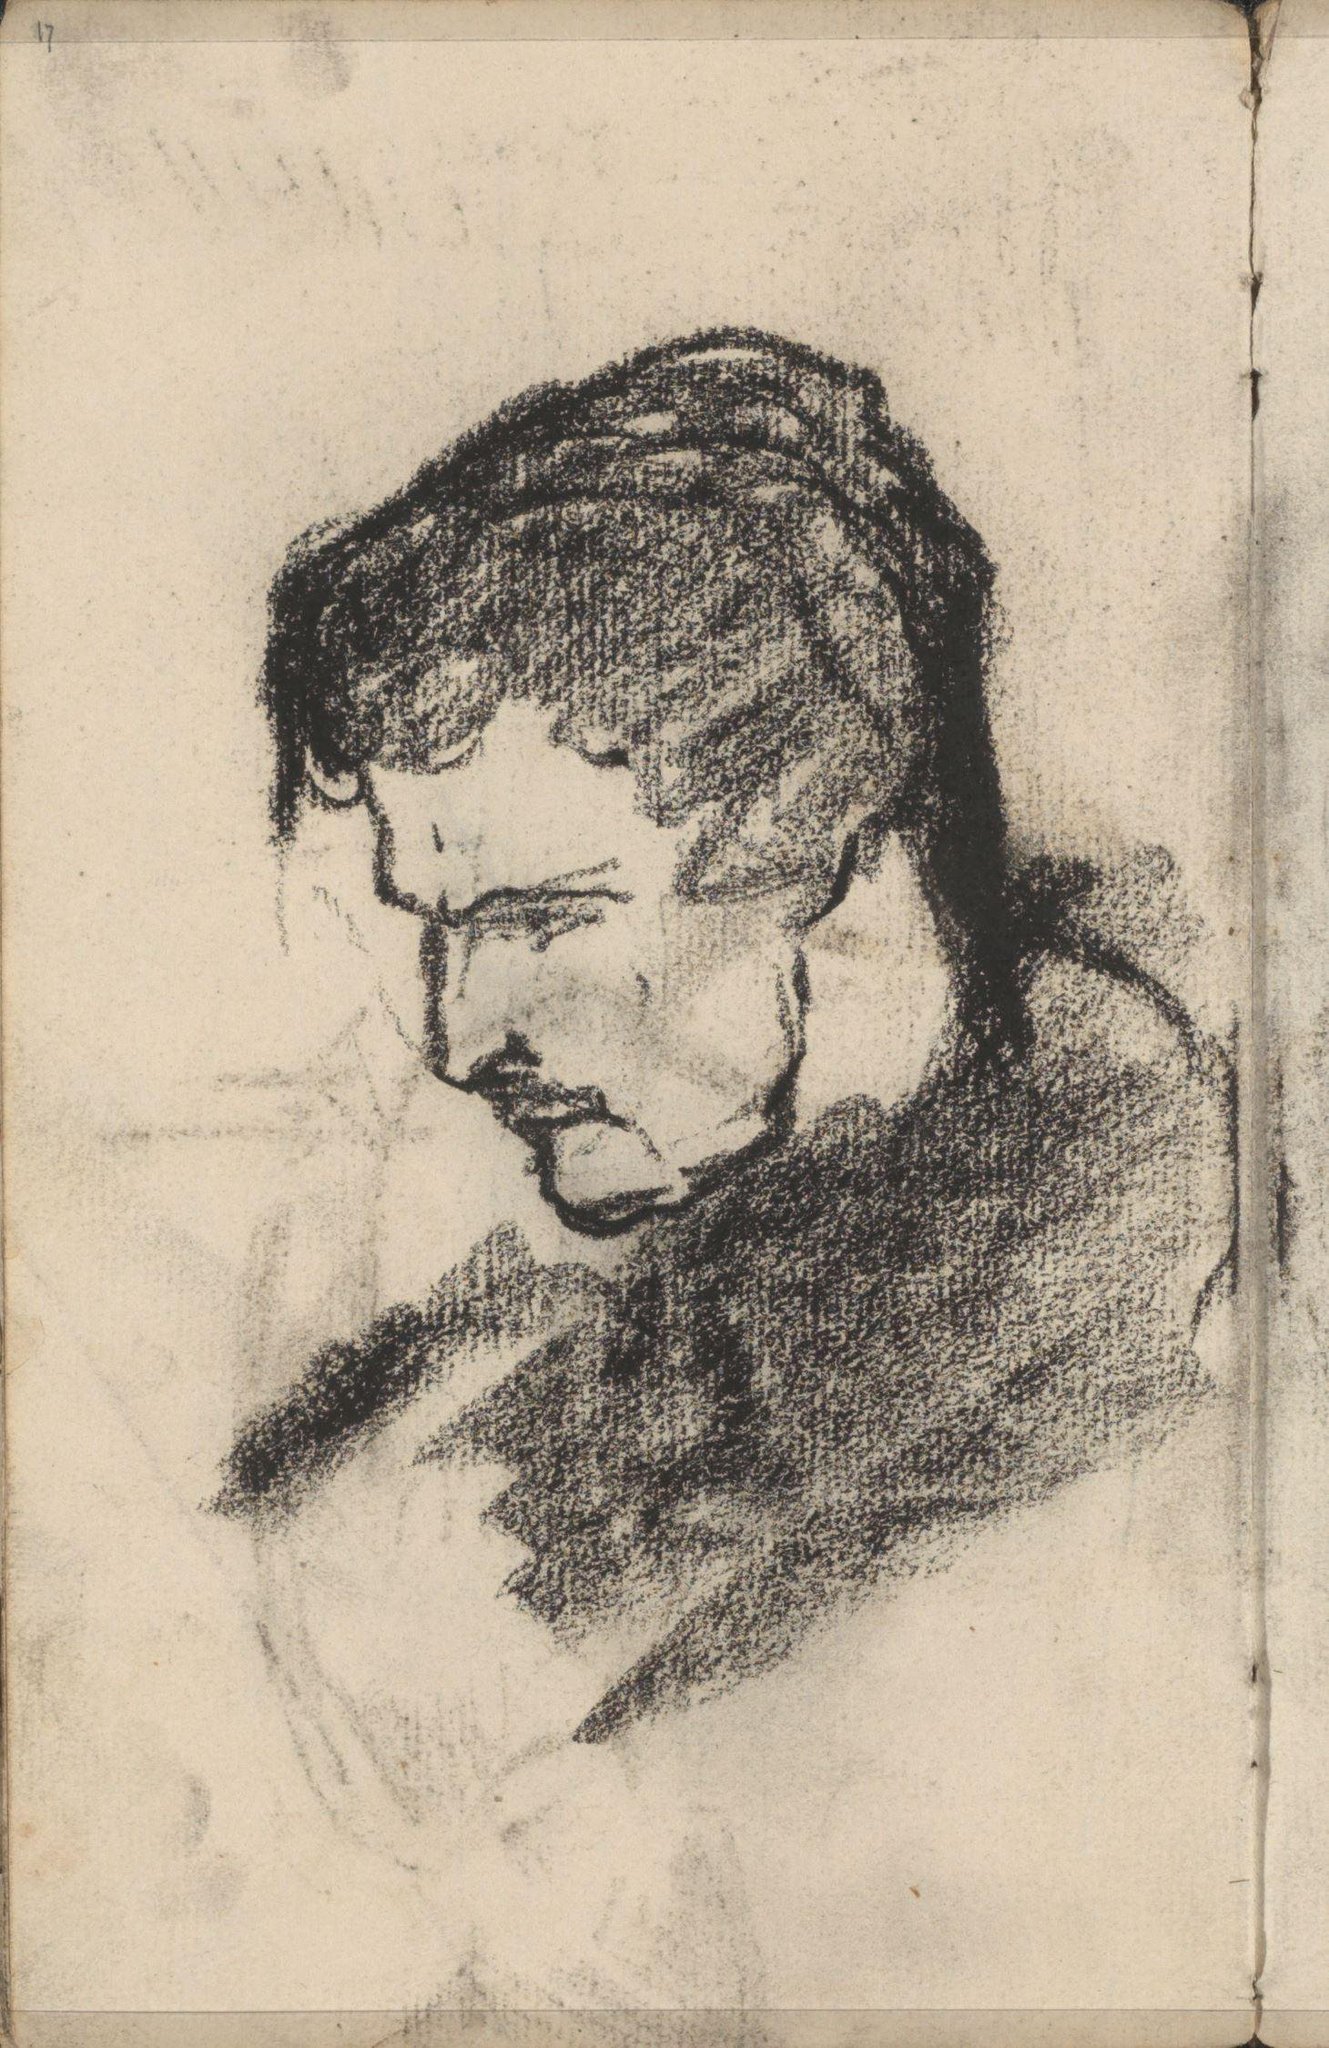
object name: sketchbook leaf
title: Buste van een man, in profiel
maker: george hendrik breitner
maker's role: draughtsman, painter, print maker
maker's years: 1857-1923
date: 1884-1886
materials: chalk, paper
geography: the hague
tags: adult man (+ sideview, profile), anonymous historical person portrayed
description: De geportretteerde lijkt sterk op de kunstenaar Frederik Hendrik Weissenbruch, maar dit lijkt onwaarschijnlijk gezien zijn relatief hoge leeftijd in 1884-1886.